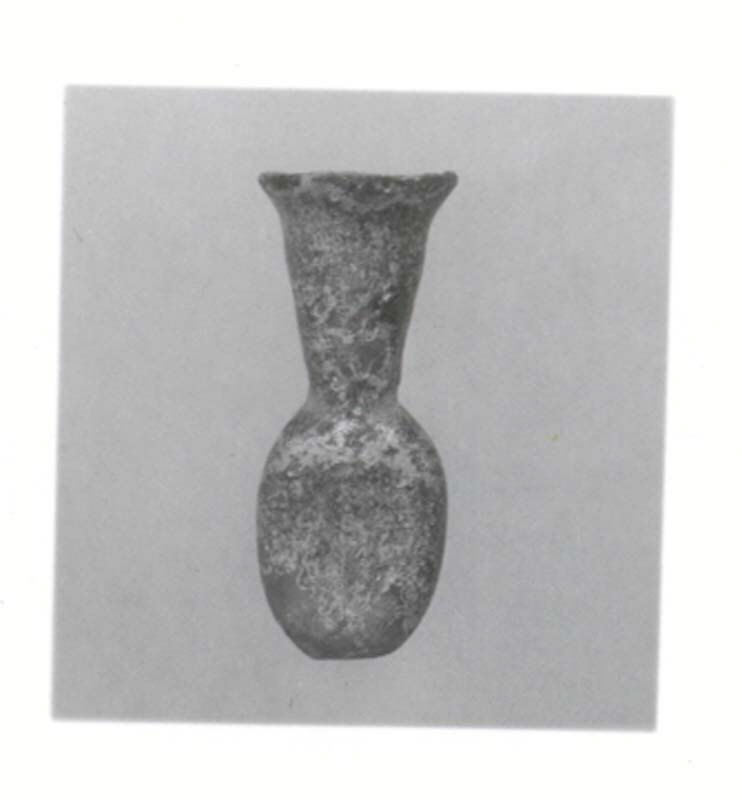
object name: bottle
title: Scent bottle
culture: sasanian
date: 201-700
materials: glass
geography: mesopotamia